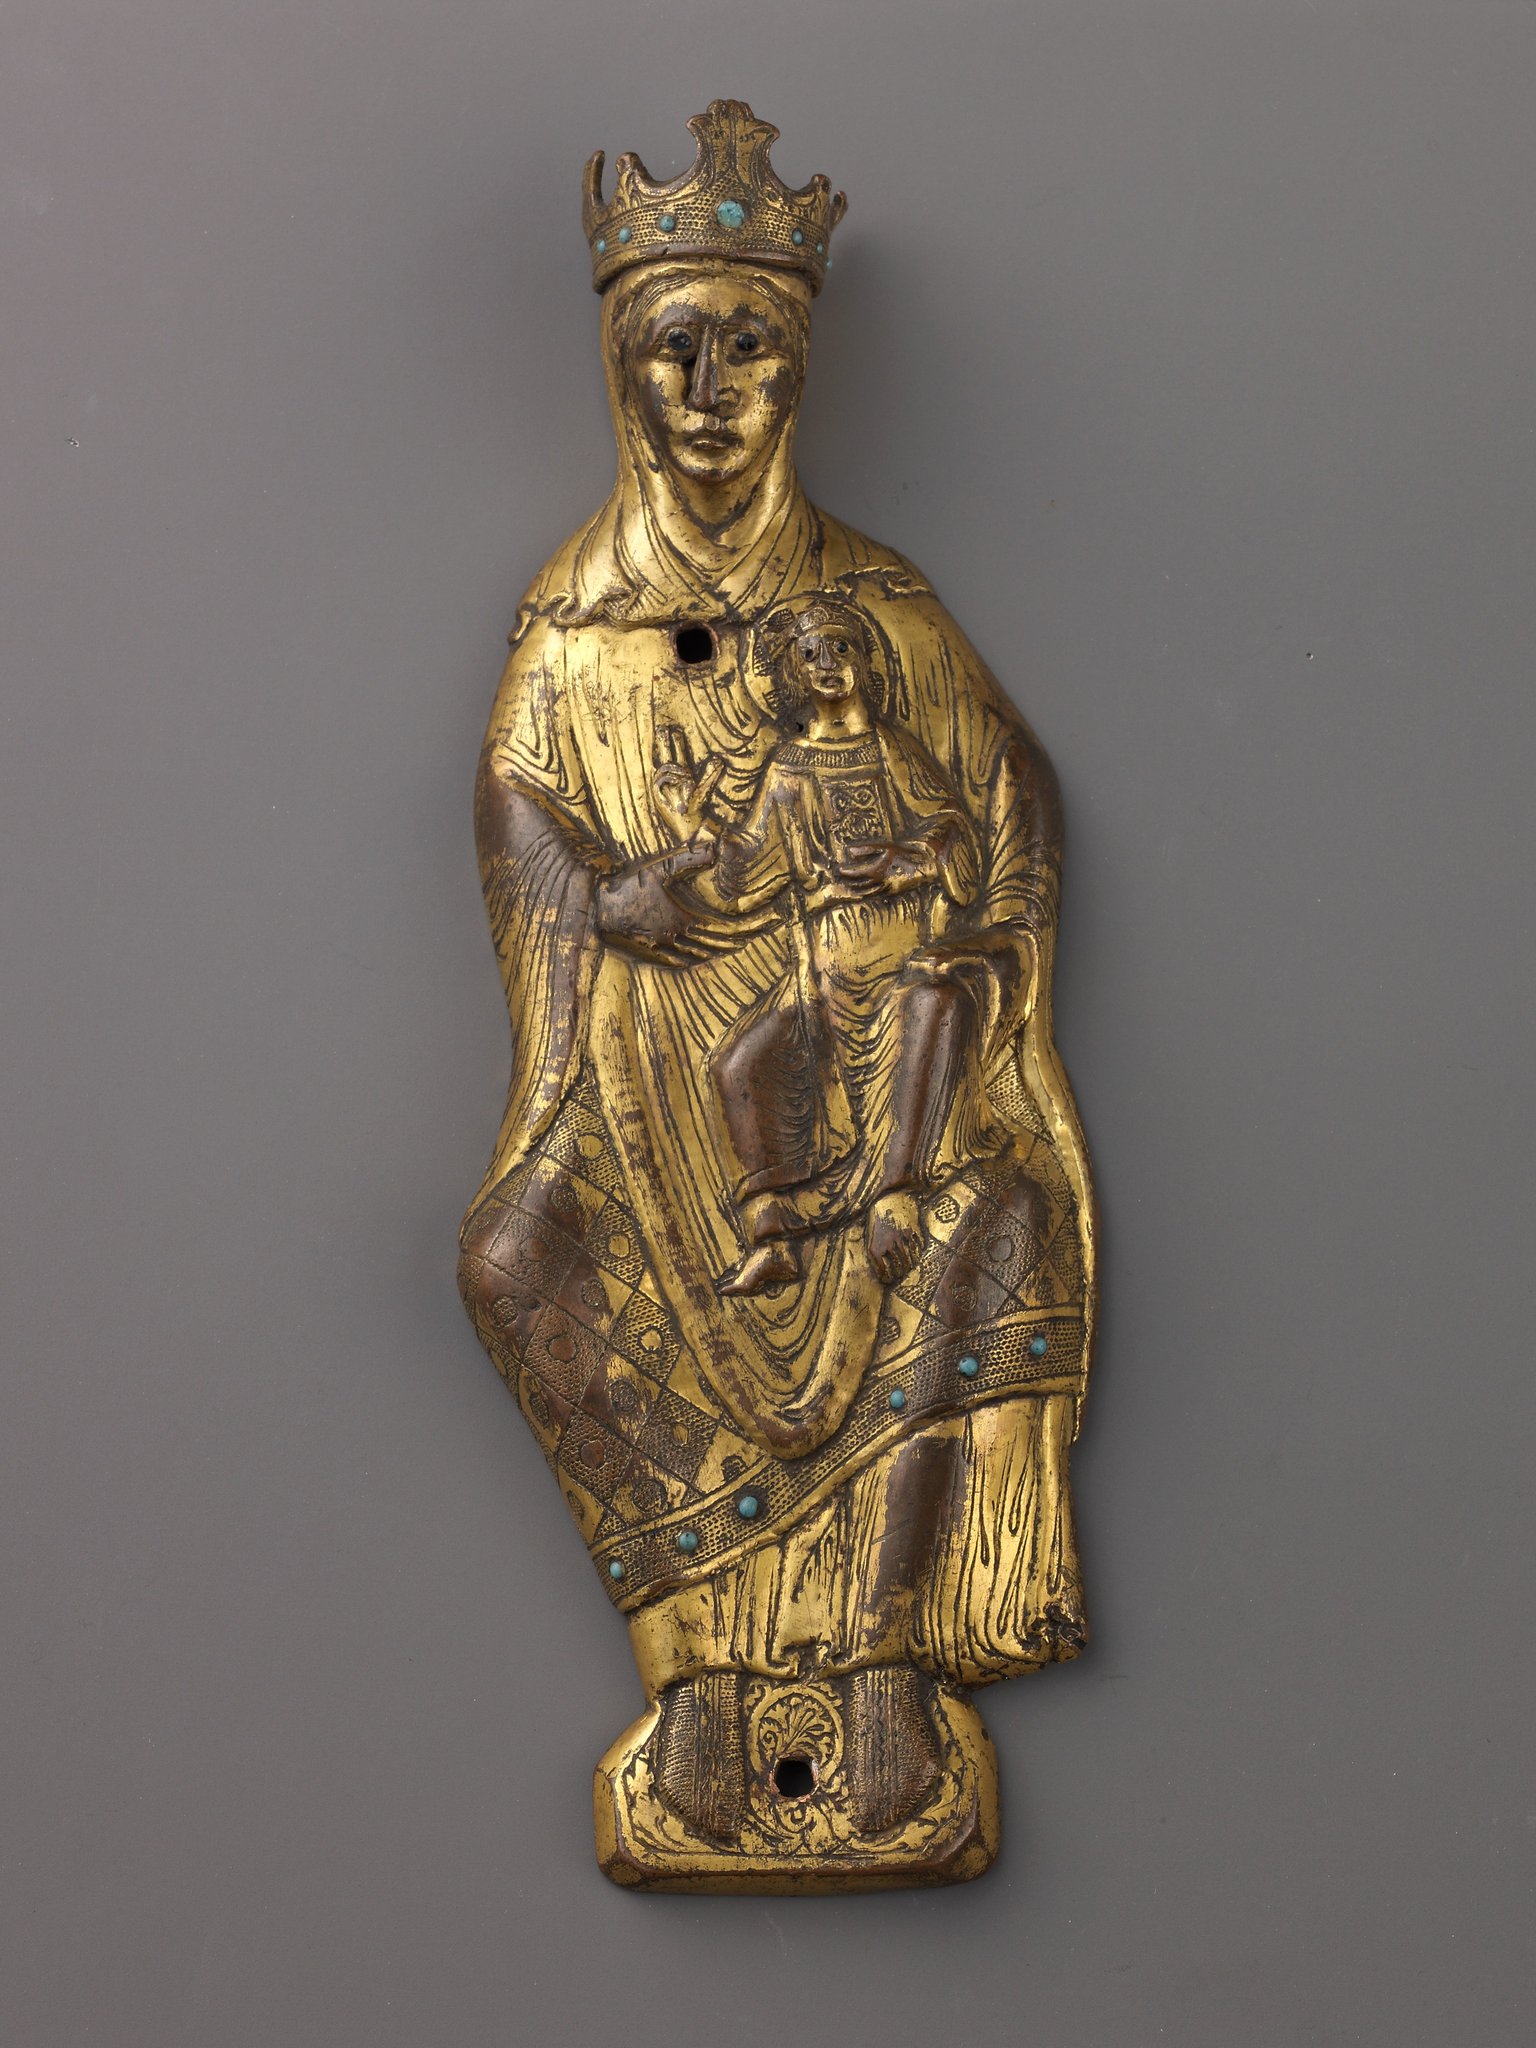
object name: plaque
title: Virgin and Child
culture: french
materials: copper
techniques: appliqué, casting, enamel, engraving, gilding, relief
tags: madonna and child